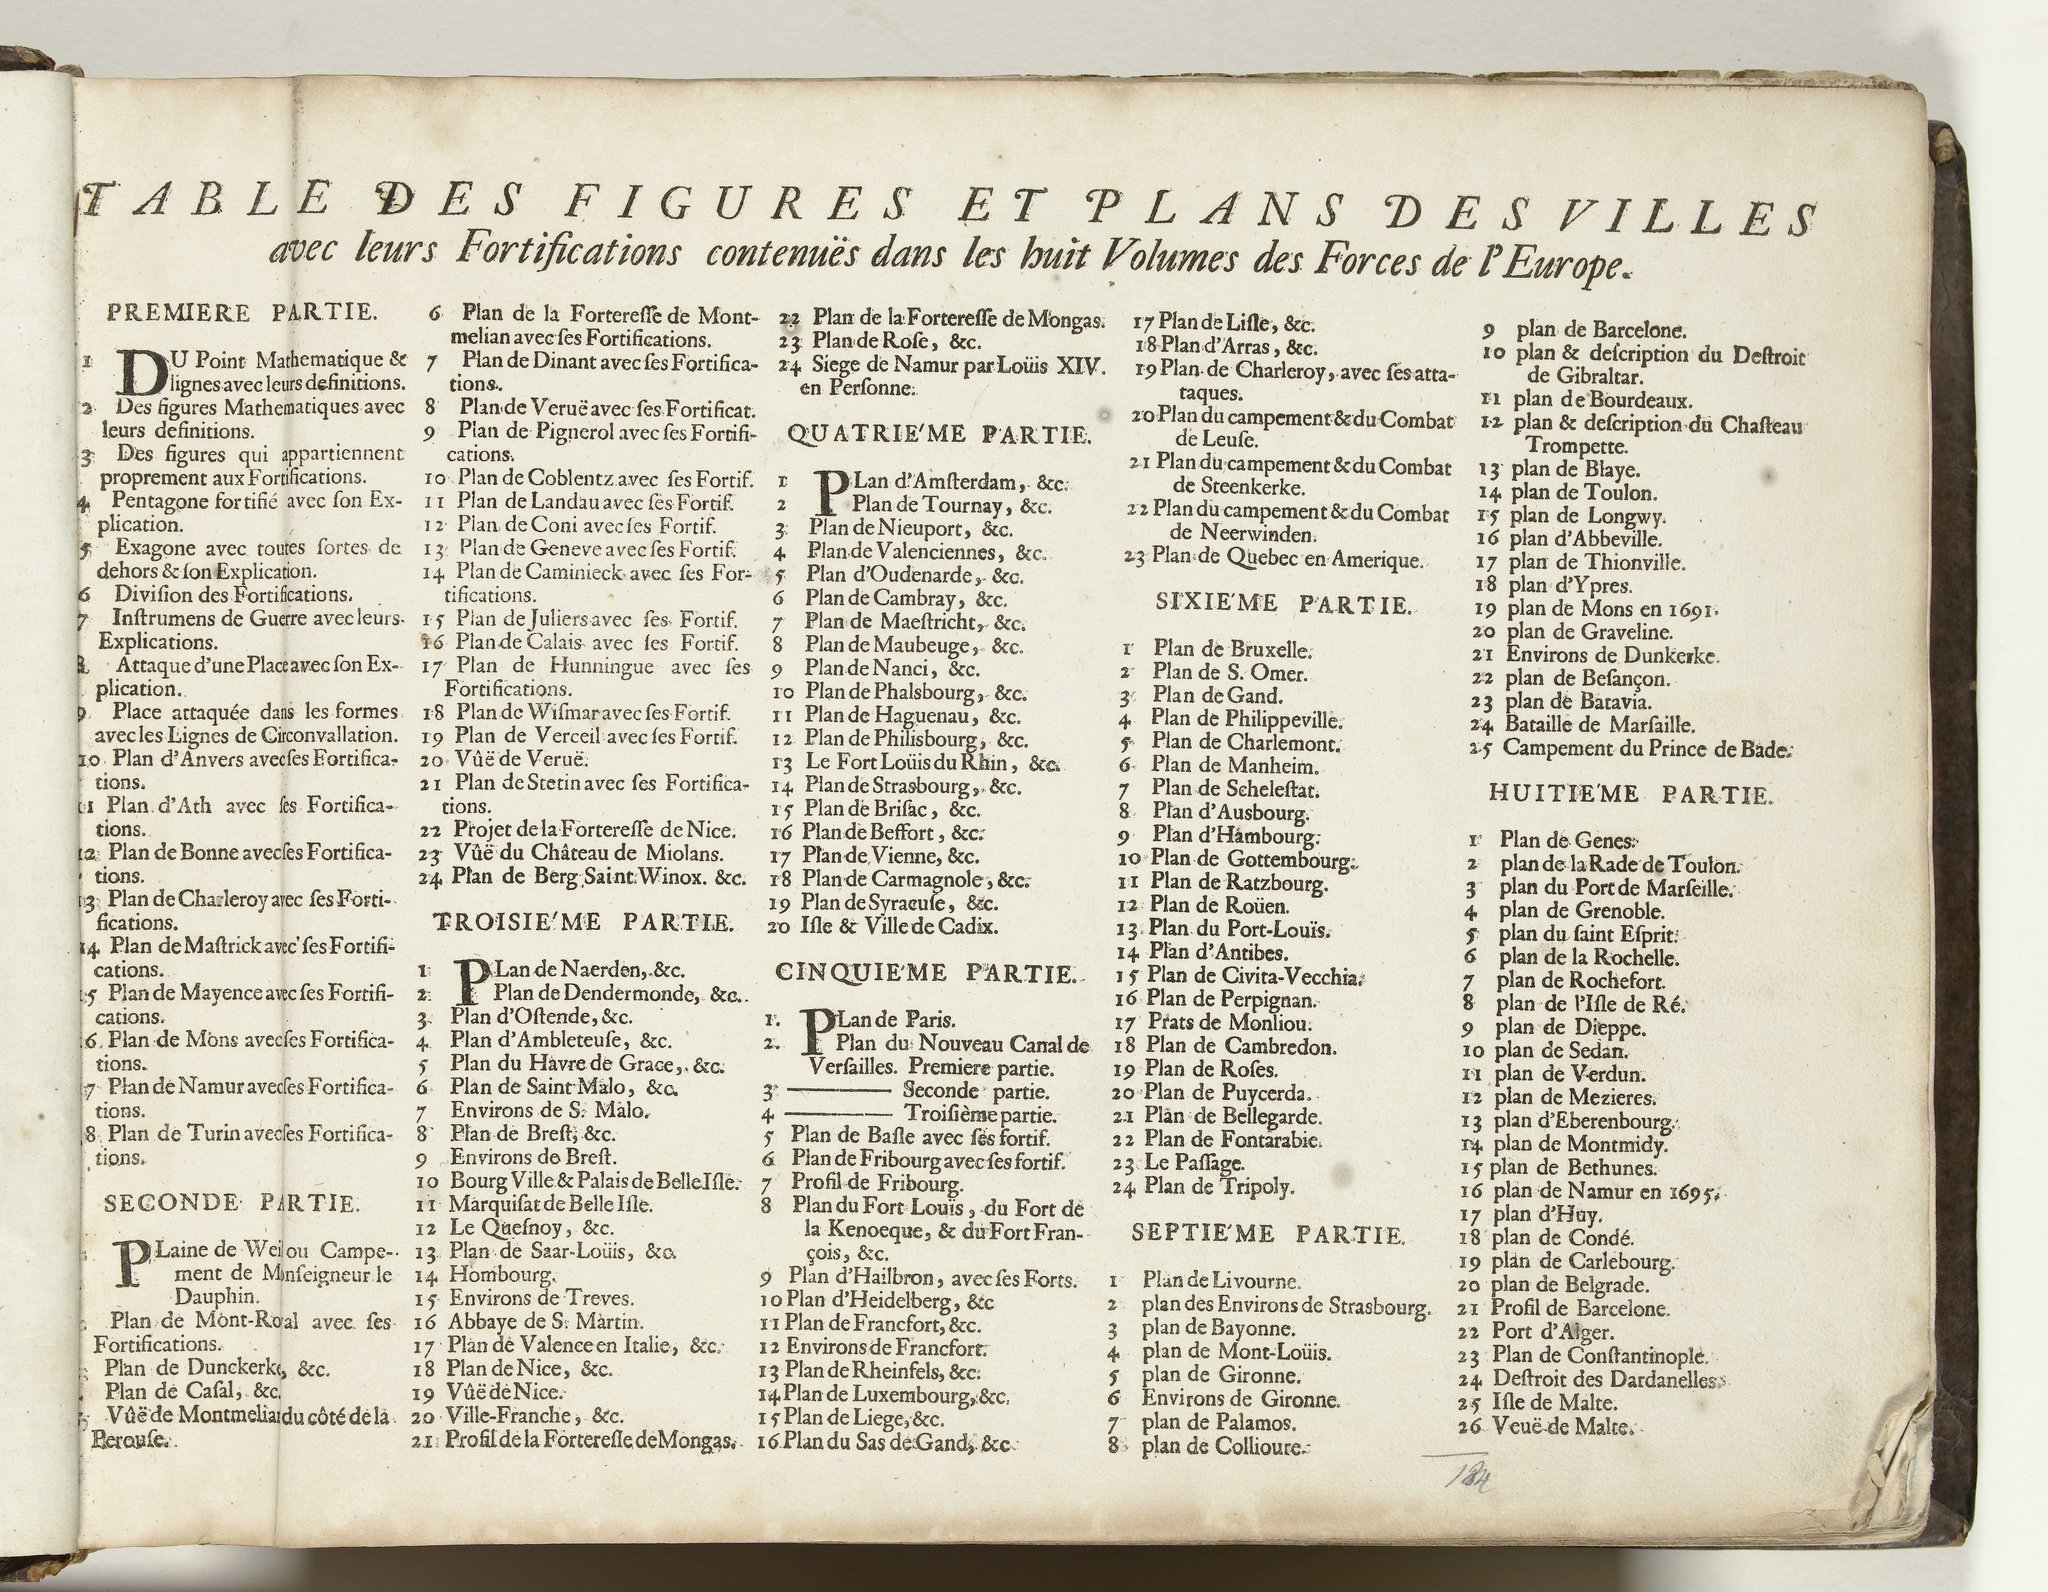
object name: text sheet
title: Inhoudsopgave op het prentwerk: Nicolas de Fer, Les forces de l'Europe, 1696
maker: nicolas de fer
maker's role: publisher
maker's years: 1647-1720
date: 1696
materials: paper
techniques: letterpress printing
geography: paris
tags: negenjarige oorlog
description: Inhoudsopgave met een lijst van alle platen per deel in het gehele prentwerk waarin gebundeld zijn de acht delen van Les forces de l'Europe uitgegeven tussen 1693-1697. Het prentwerk bestaat uit 175 platen met plannen (afkomstig van Sébastien Le Prestre, Seigneur de Vauban) van vermaarde sterke steden en vestingen in de Negenjarige Oorlog. Titel in het Frans.